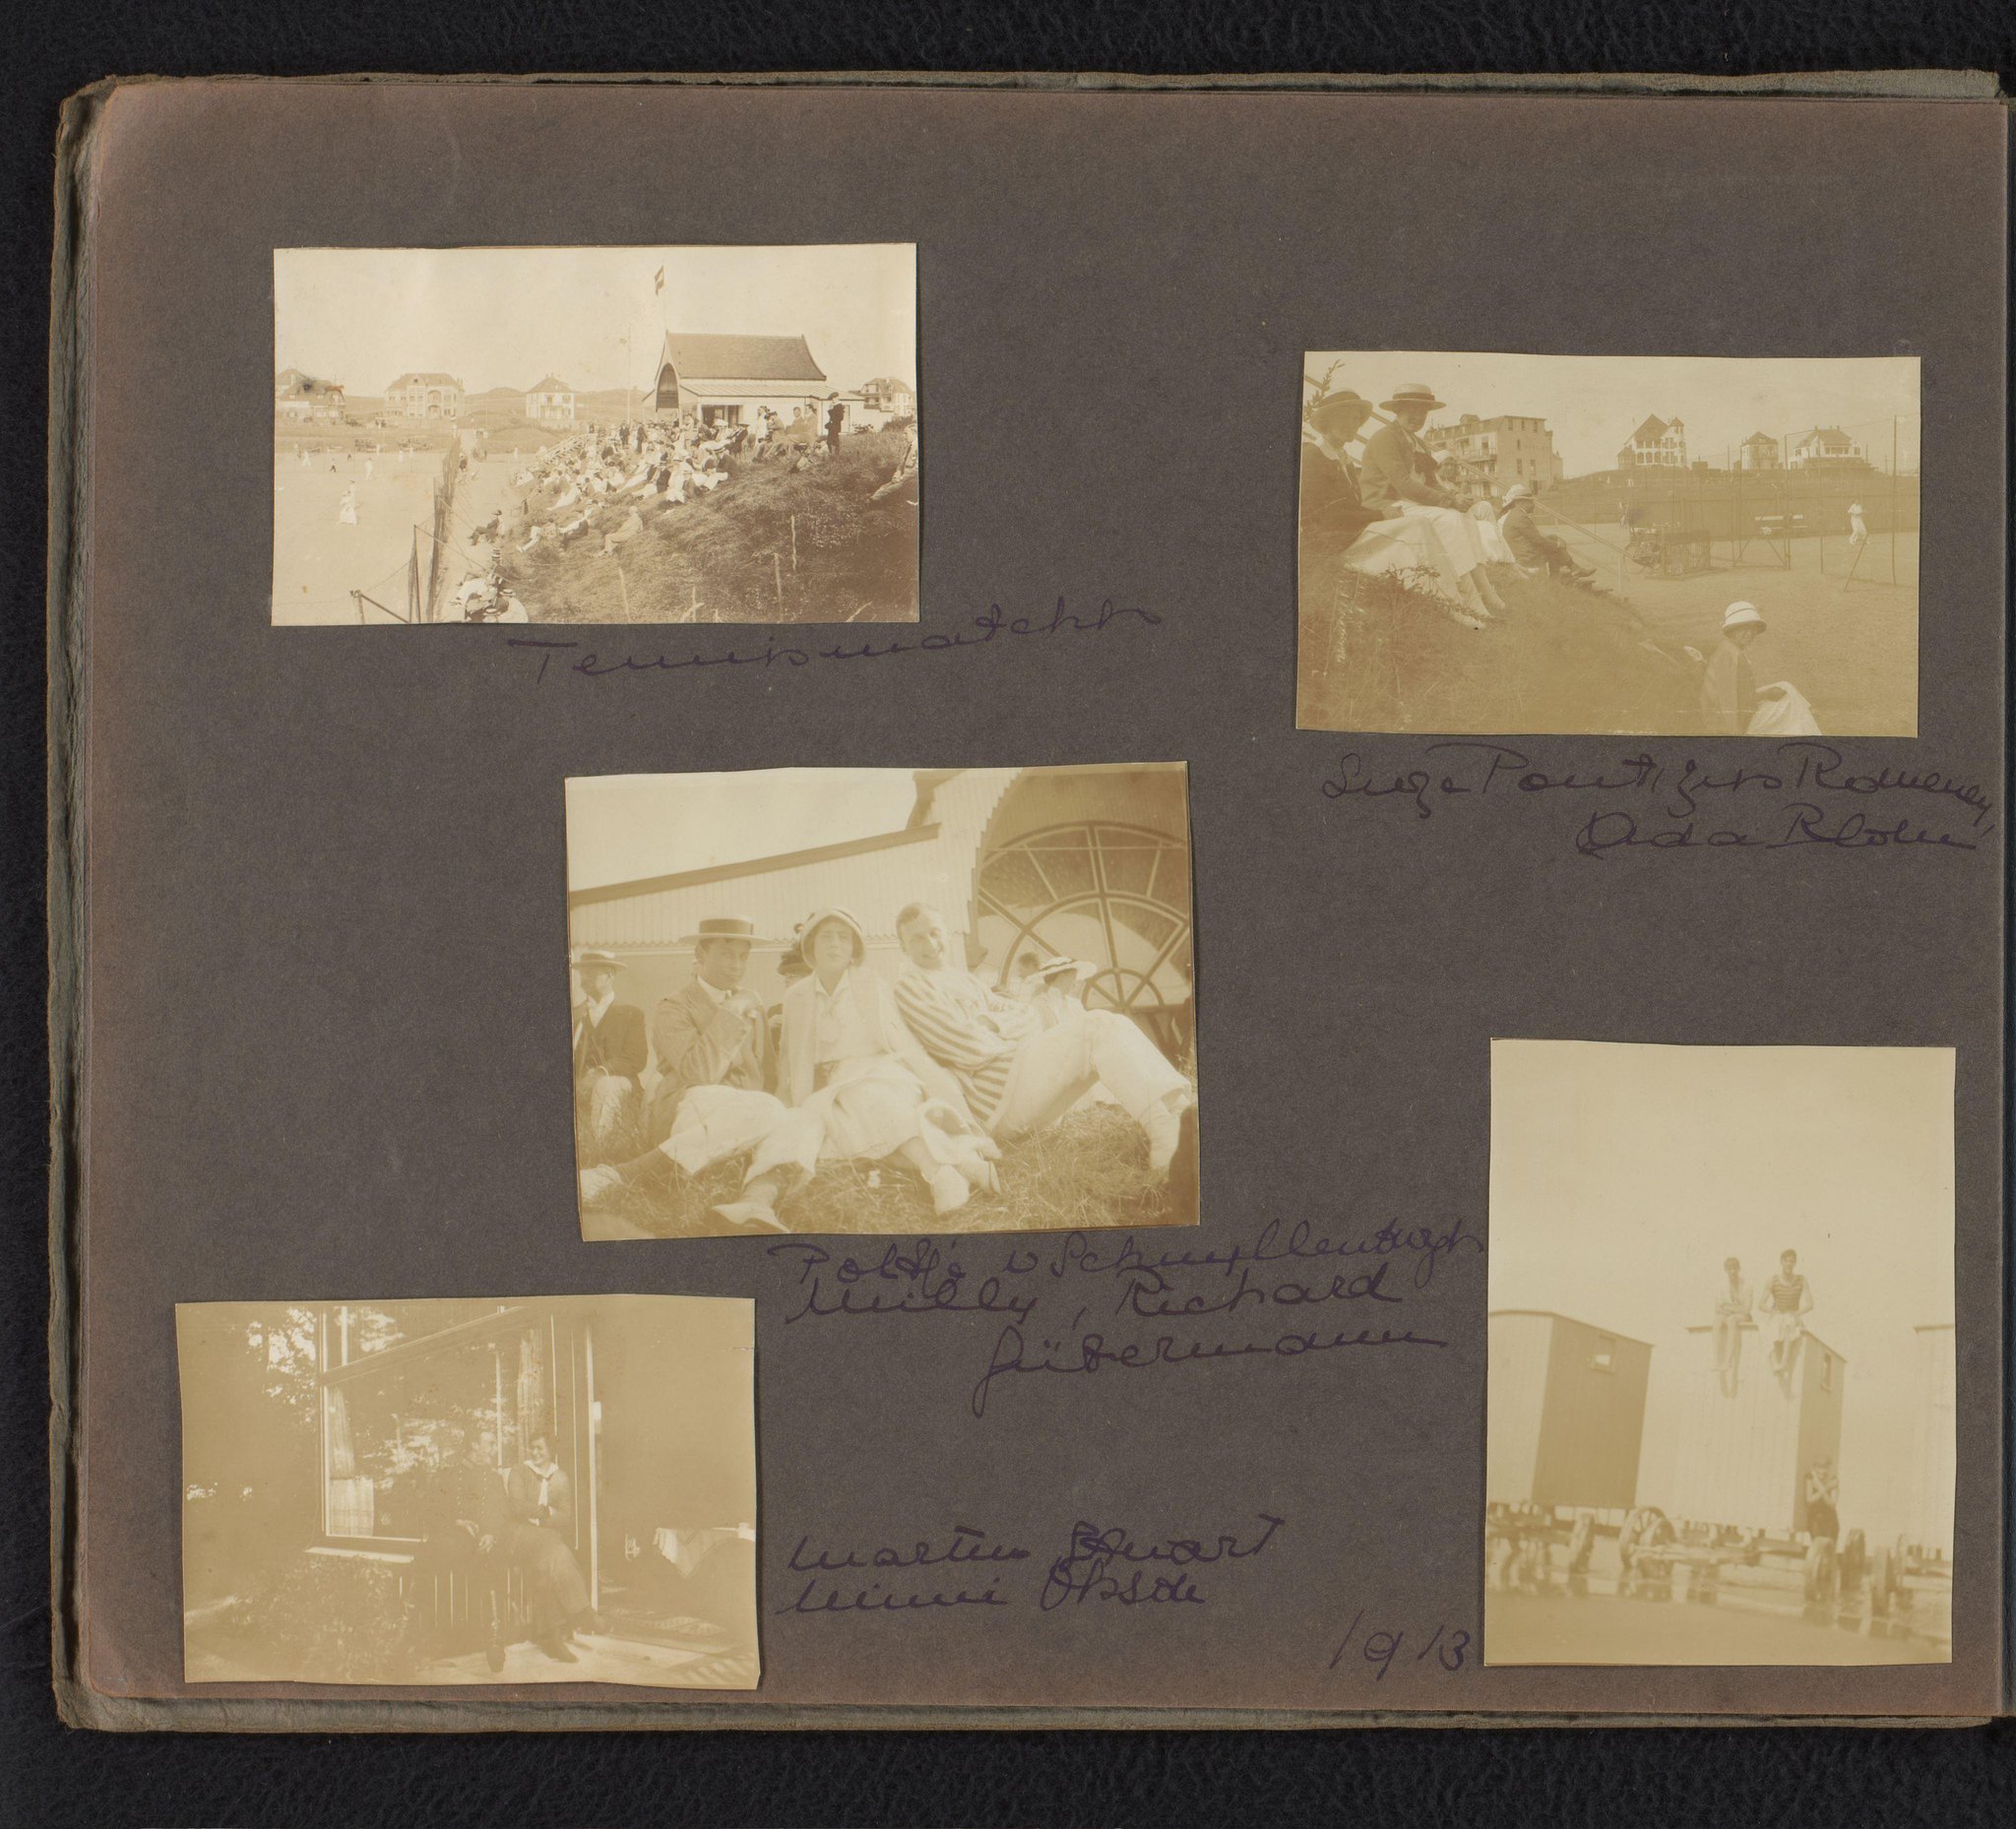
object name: photograph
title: Publiek tijdens een tenniswedstrijd in Noordwijk, waaronder Suze Paut, Jan Roweney [?], Ada Bloem, Pollie van Schuyllenburgh, Willy Onnen, Richard Füßermann [?], Martin Zwart en Winnie Oksde [?]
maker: Anonymous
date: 1913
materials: paper, cardboard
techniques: gelatin silver print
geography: noordwijk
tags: emilie albertina onnen (milly), tennis, lawn-tennis, historical persons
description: Deze foto's zijn onderdeel van een album.